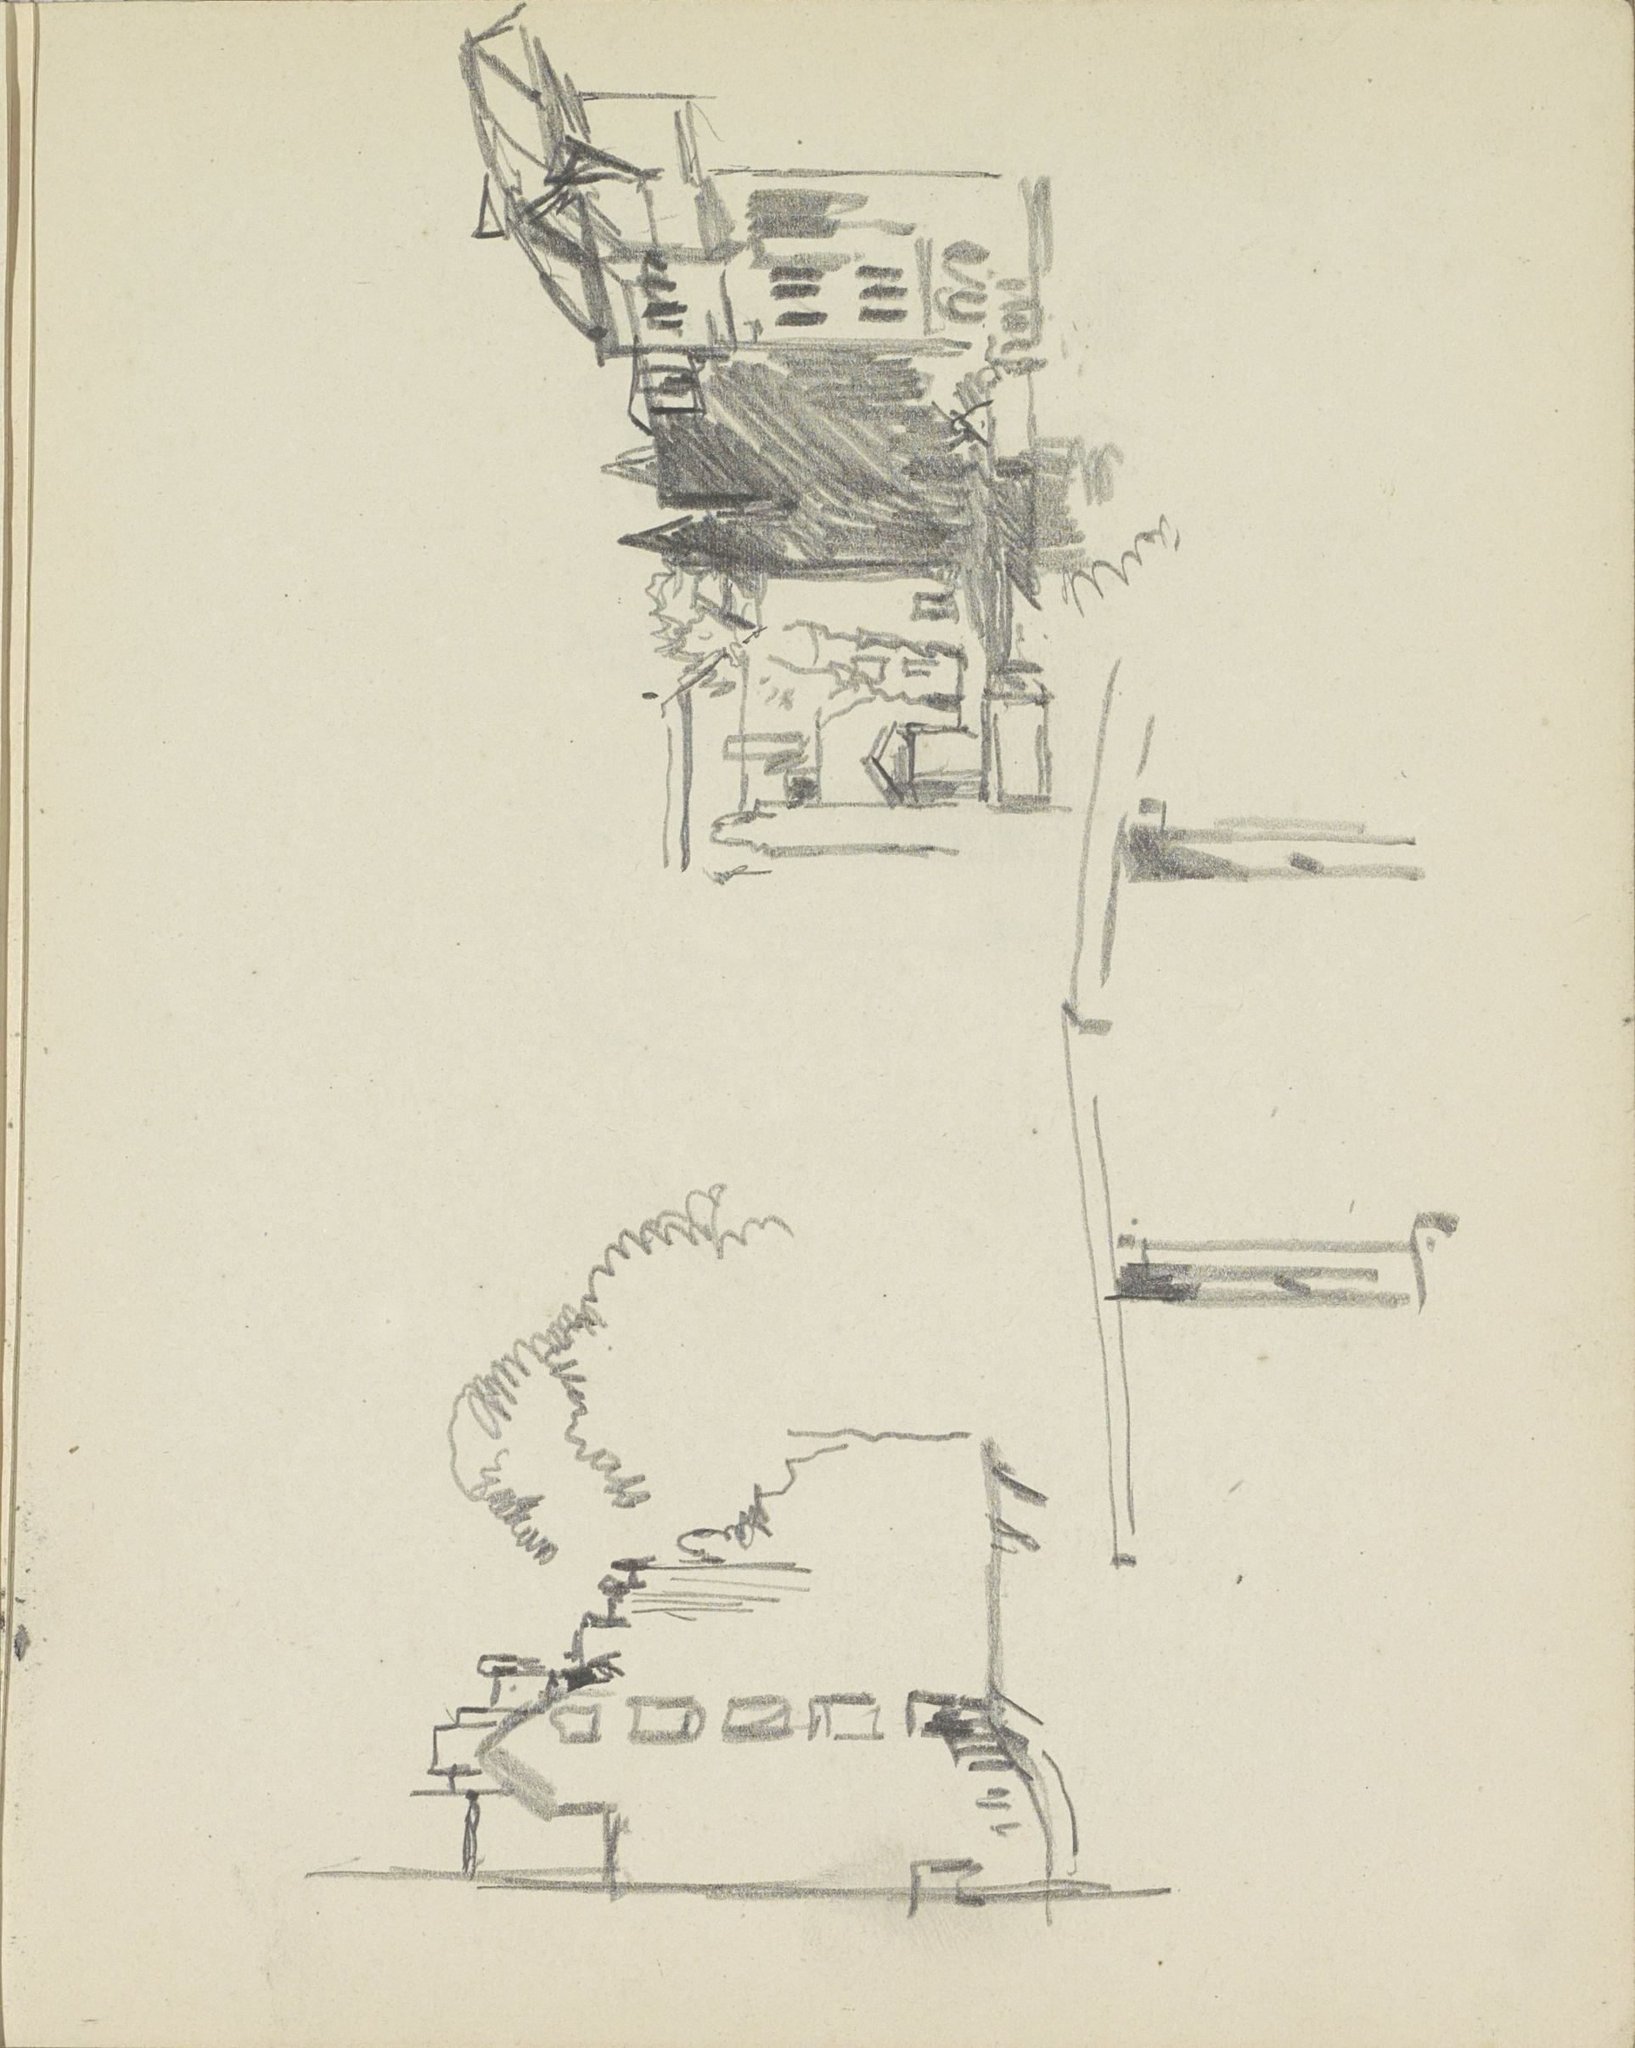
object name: sketchbook leaf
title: Huizen aan een gracht en een ophaalbrug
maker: cornelis vreedenburgh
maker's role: draughtsman, print maker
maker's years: 1880-1946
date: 1890-1946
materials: paper, pencil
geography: amsterdam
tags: bridge, street, amsterdam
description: Blad 11 recto uit een schetsboek met 76 bladen.